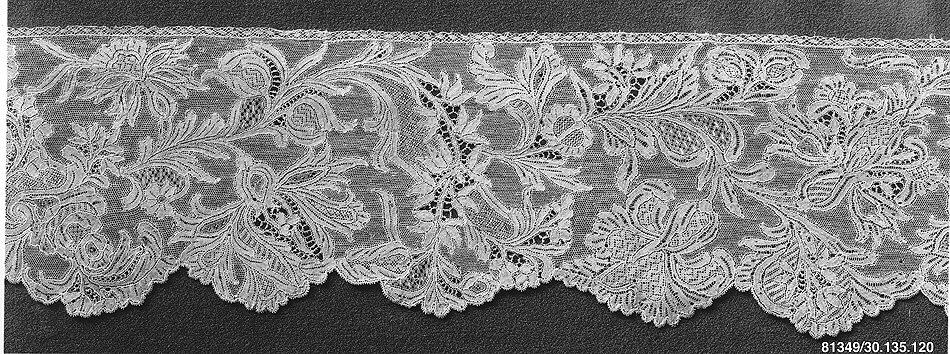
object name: border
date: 1701-1800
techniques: lace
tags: flowers